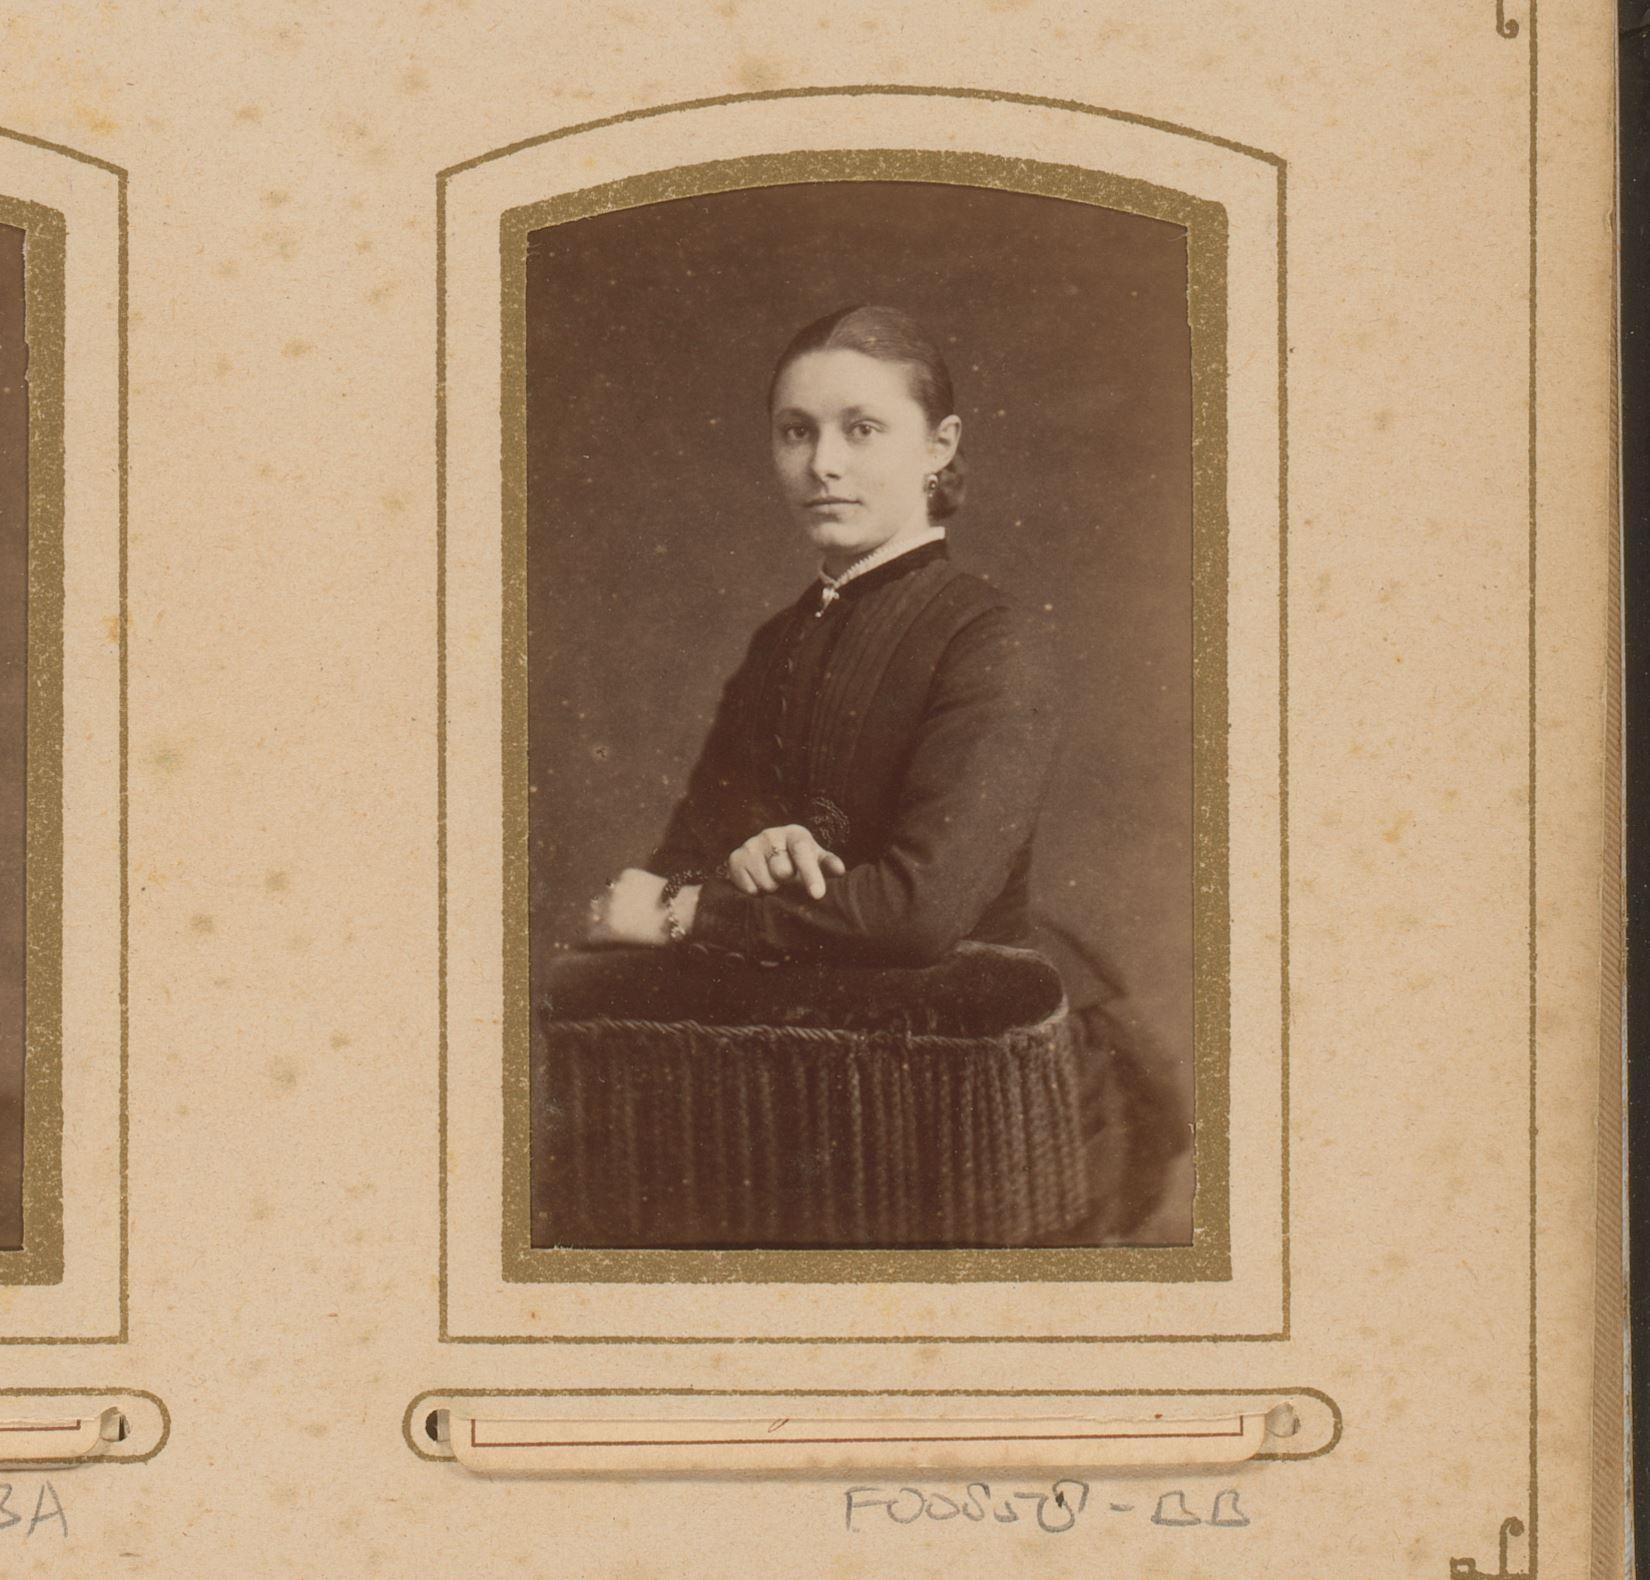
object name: album leaf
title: Portret van een jonge vrouw, leunend op een stoel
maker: albert a. kleintjes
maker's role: fotograaf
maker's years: 1854-1942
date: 1883-1900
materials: cardboard, photographic support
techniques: albumen print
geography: hoorn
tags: adolescent, young woman, maiden, historical persons - bb - woman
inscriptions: inscription: ‘Hoorn, Kerkstraat, 4e huis v.d. Kaasmarkt’